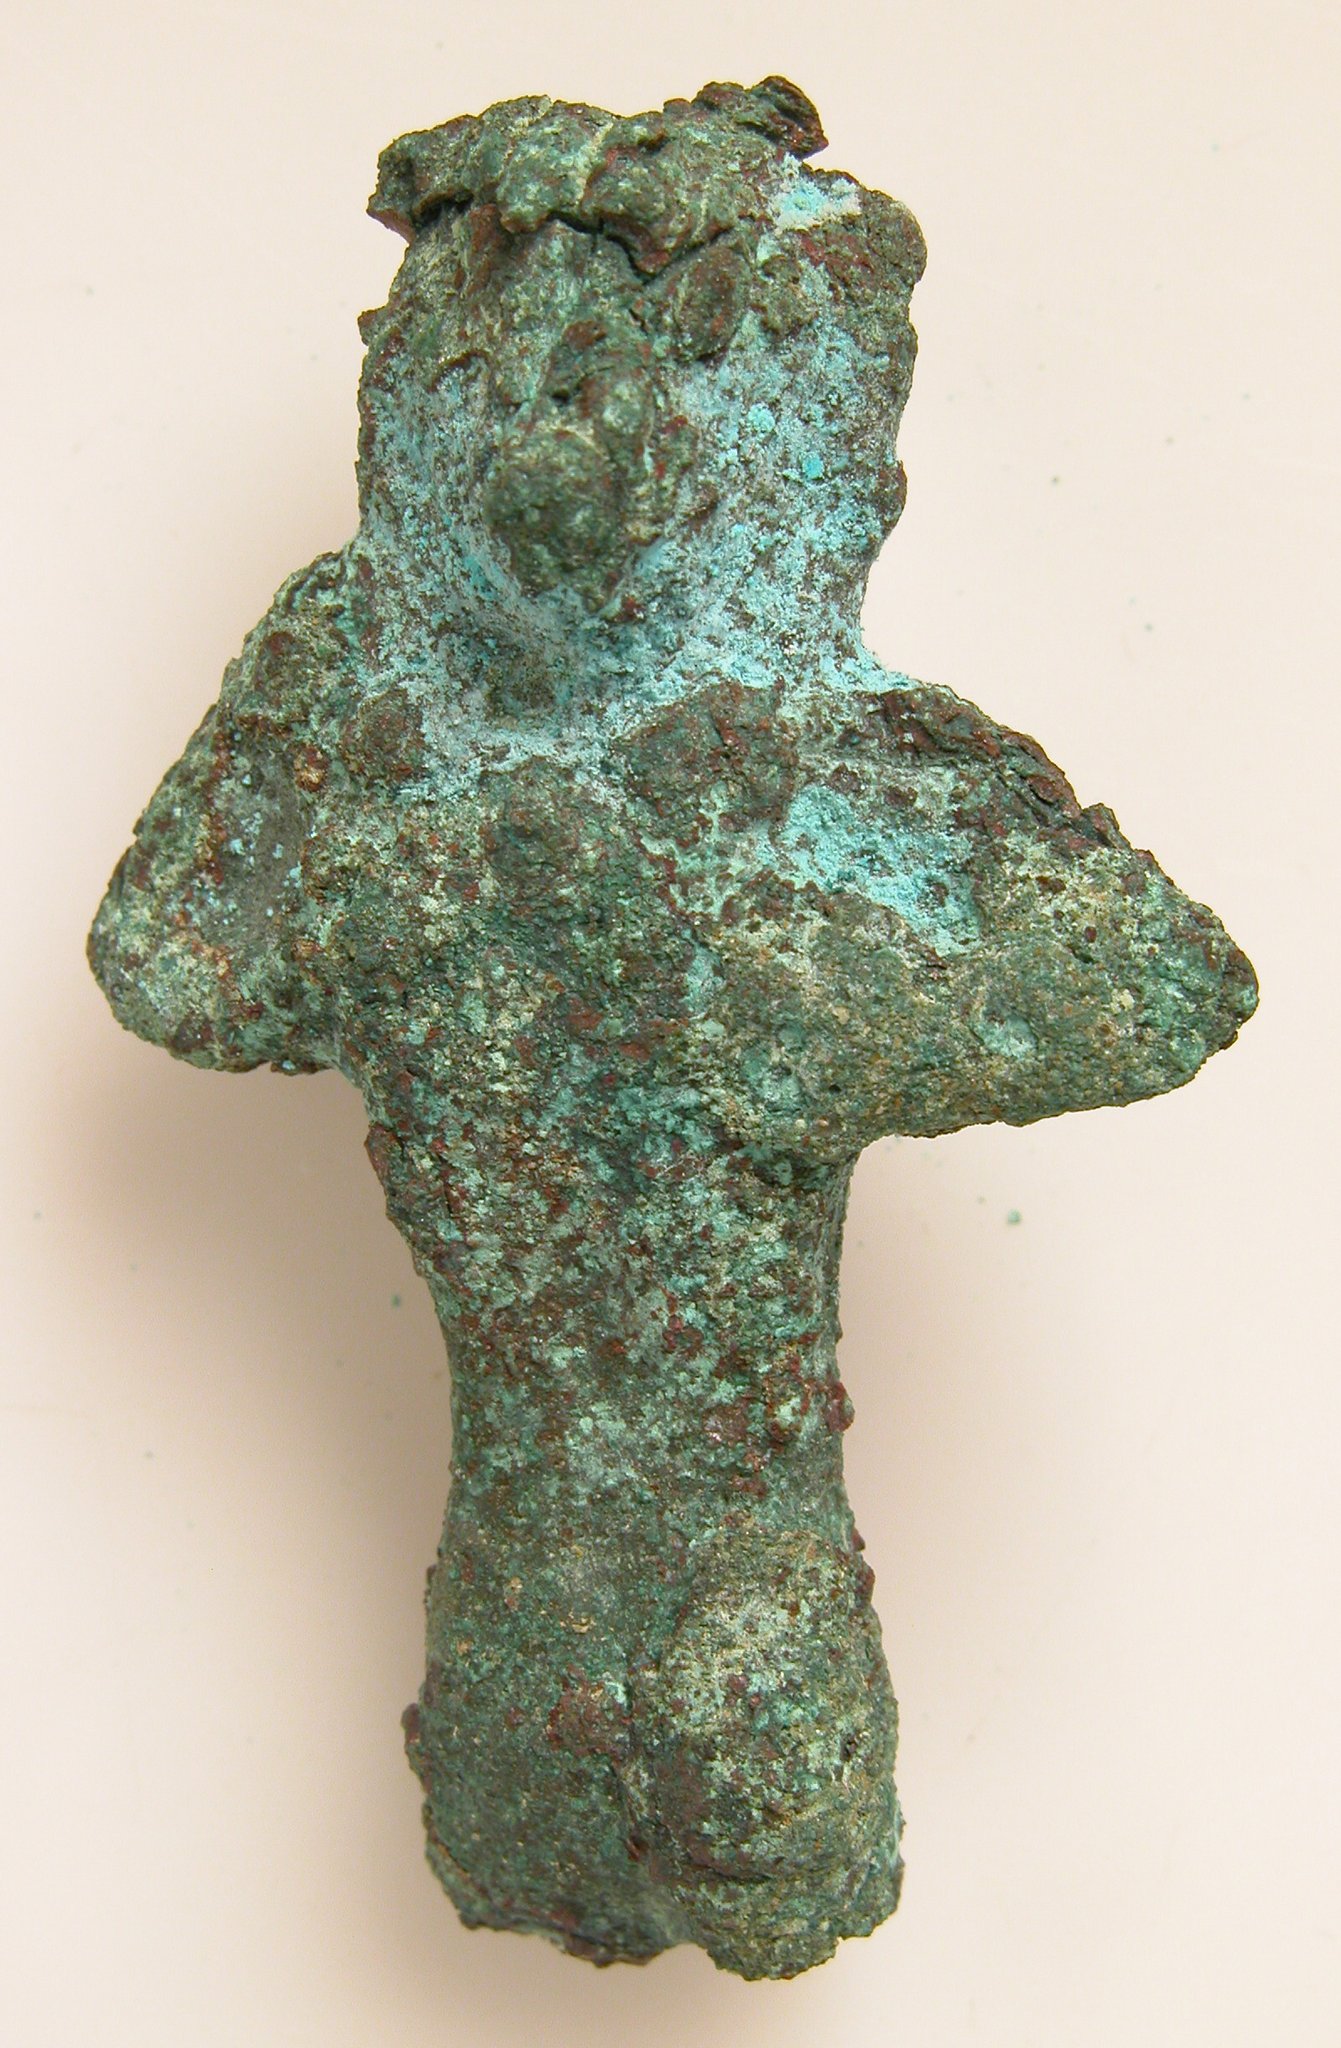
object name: statuette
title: Small Figure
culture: coptic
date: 301-700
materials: copper alloy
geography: egypt